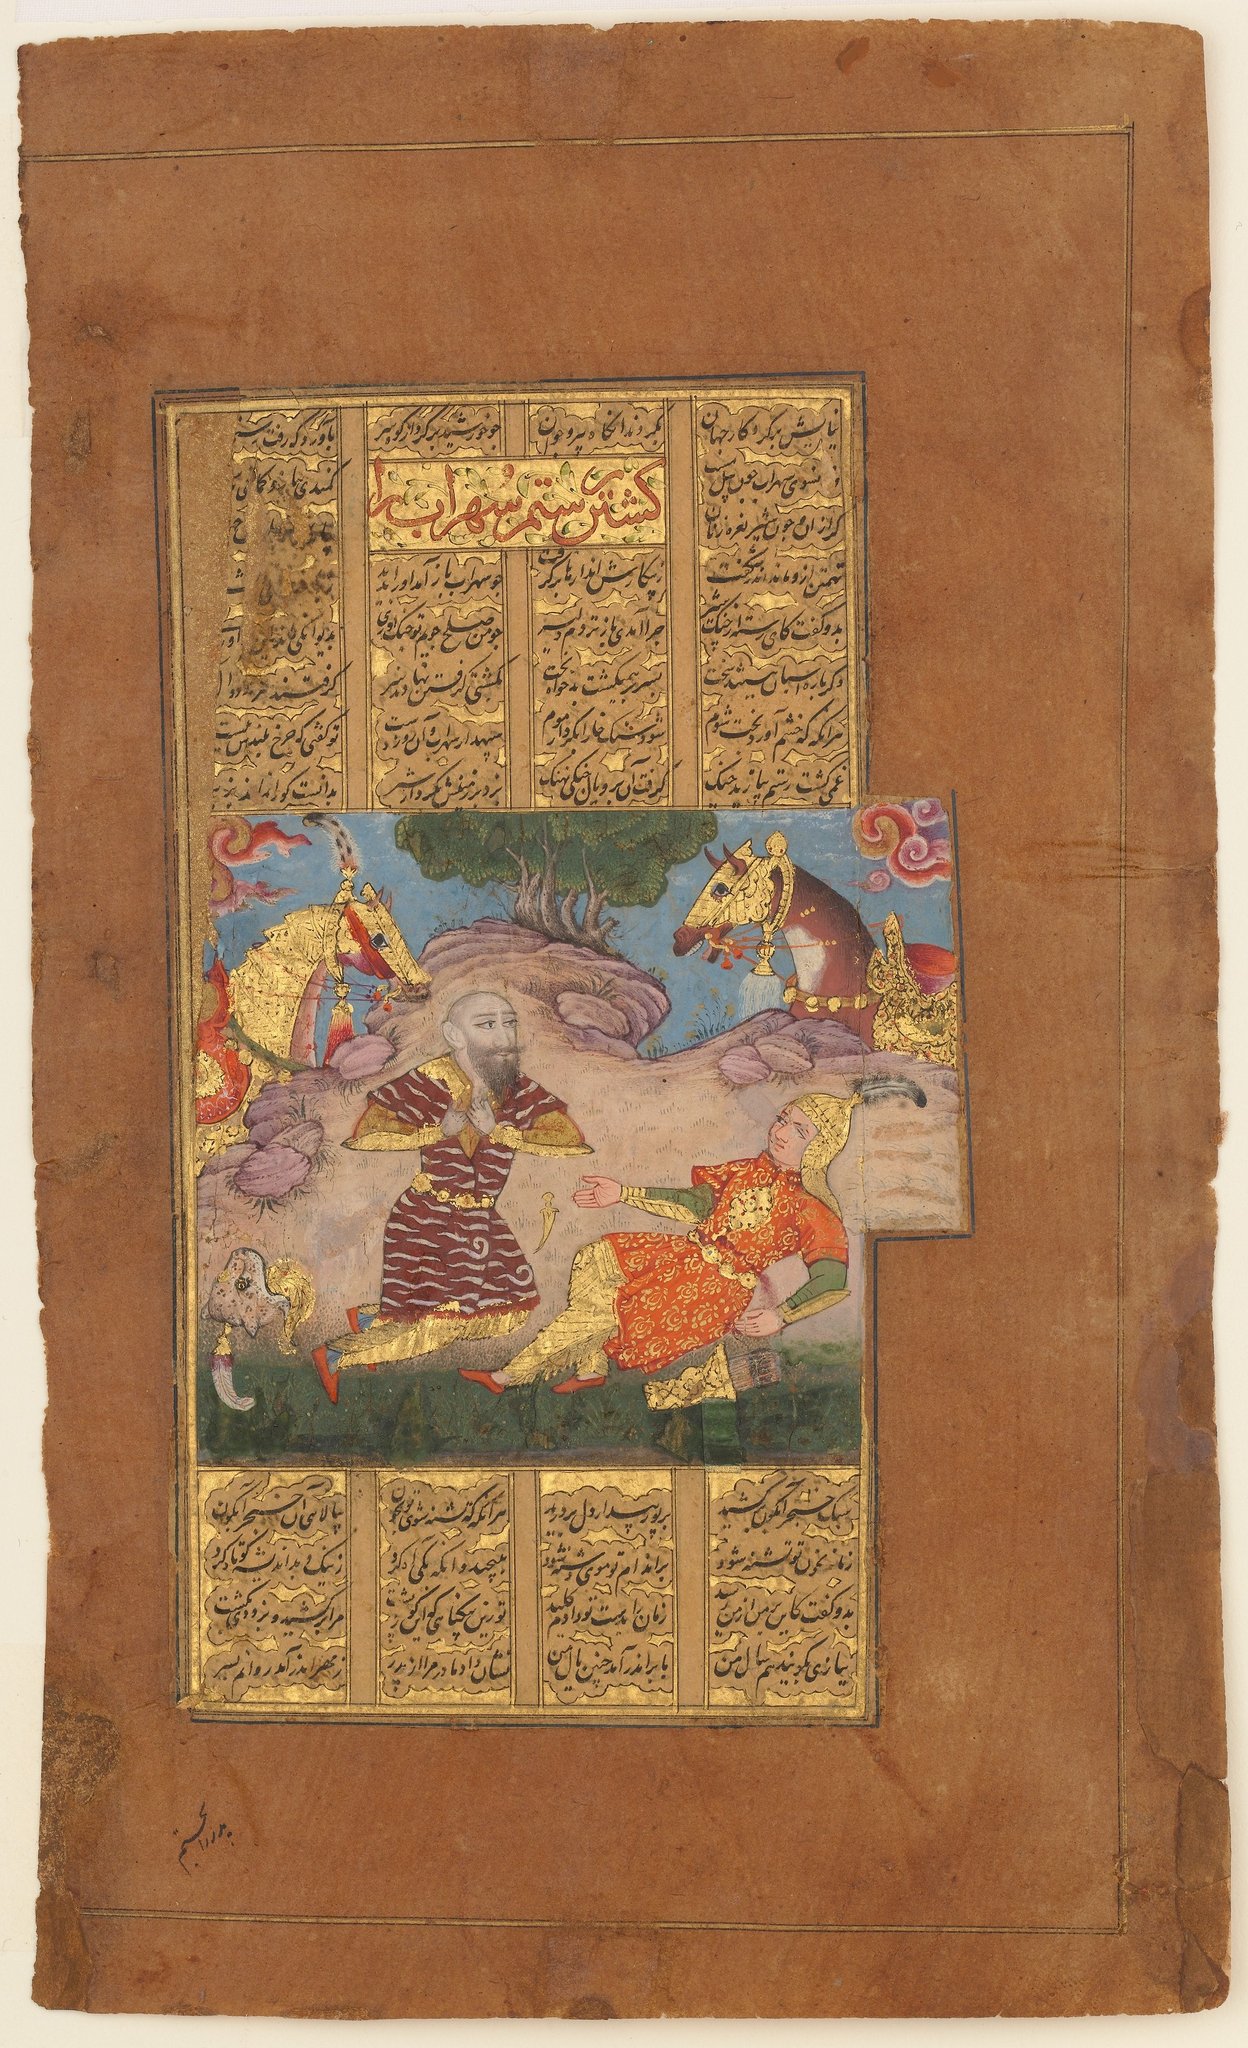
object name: folio from an illustrated manuscript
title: "Suhrab Slain by Rustam", Folio from a Shahnama (Book of Kings) of Firdausi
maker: abu'l qasim firdausi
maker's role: author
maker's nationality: iranian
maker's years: 935-1020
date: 1610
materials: gold, ink, paper, watercolor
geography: india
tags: poetry,men,horses